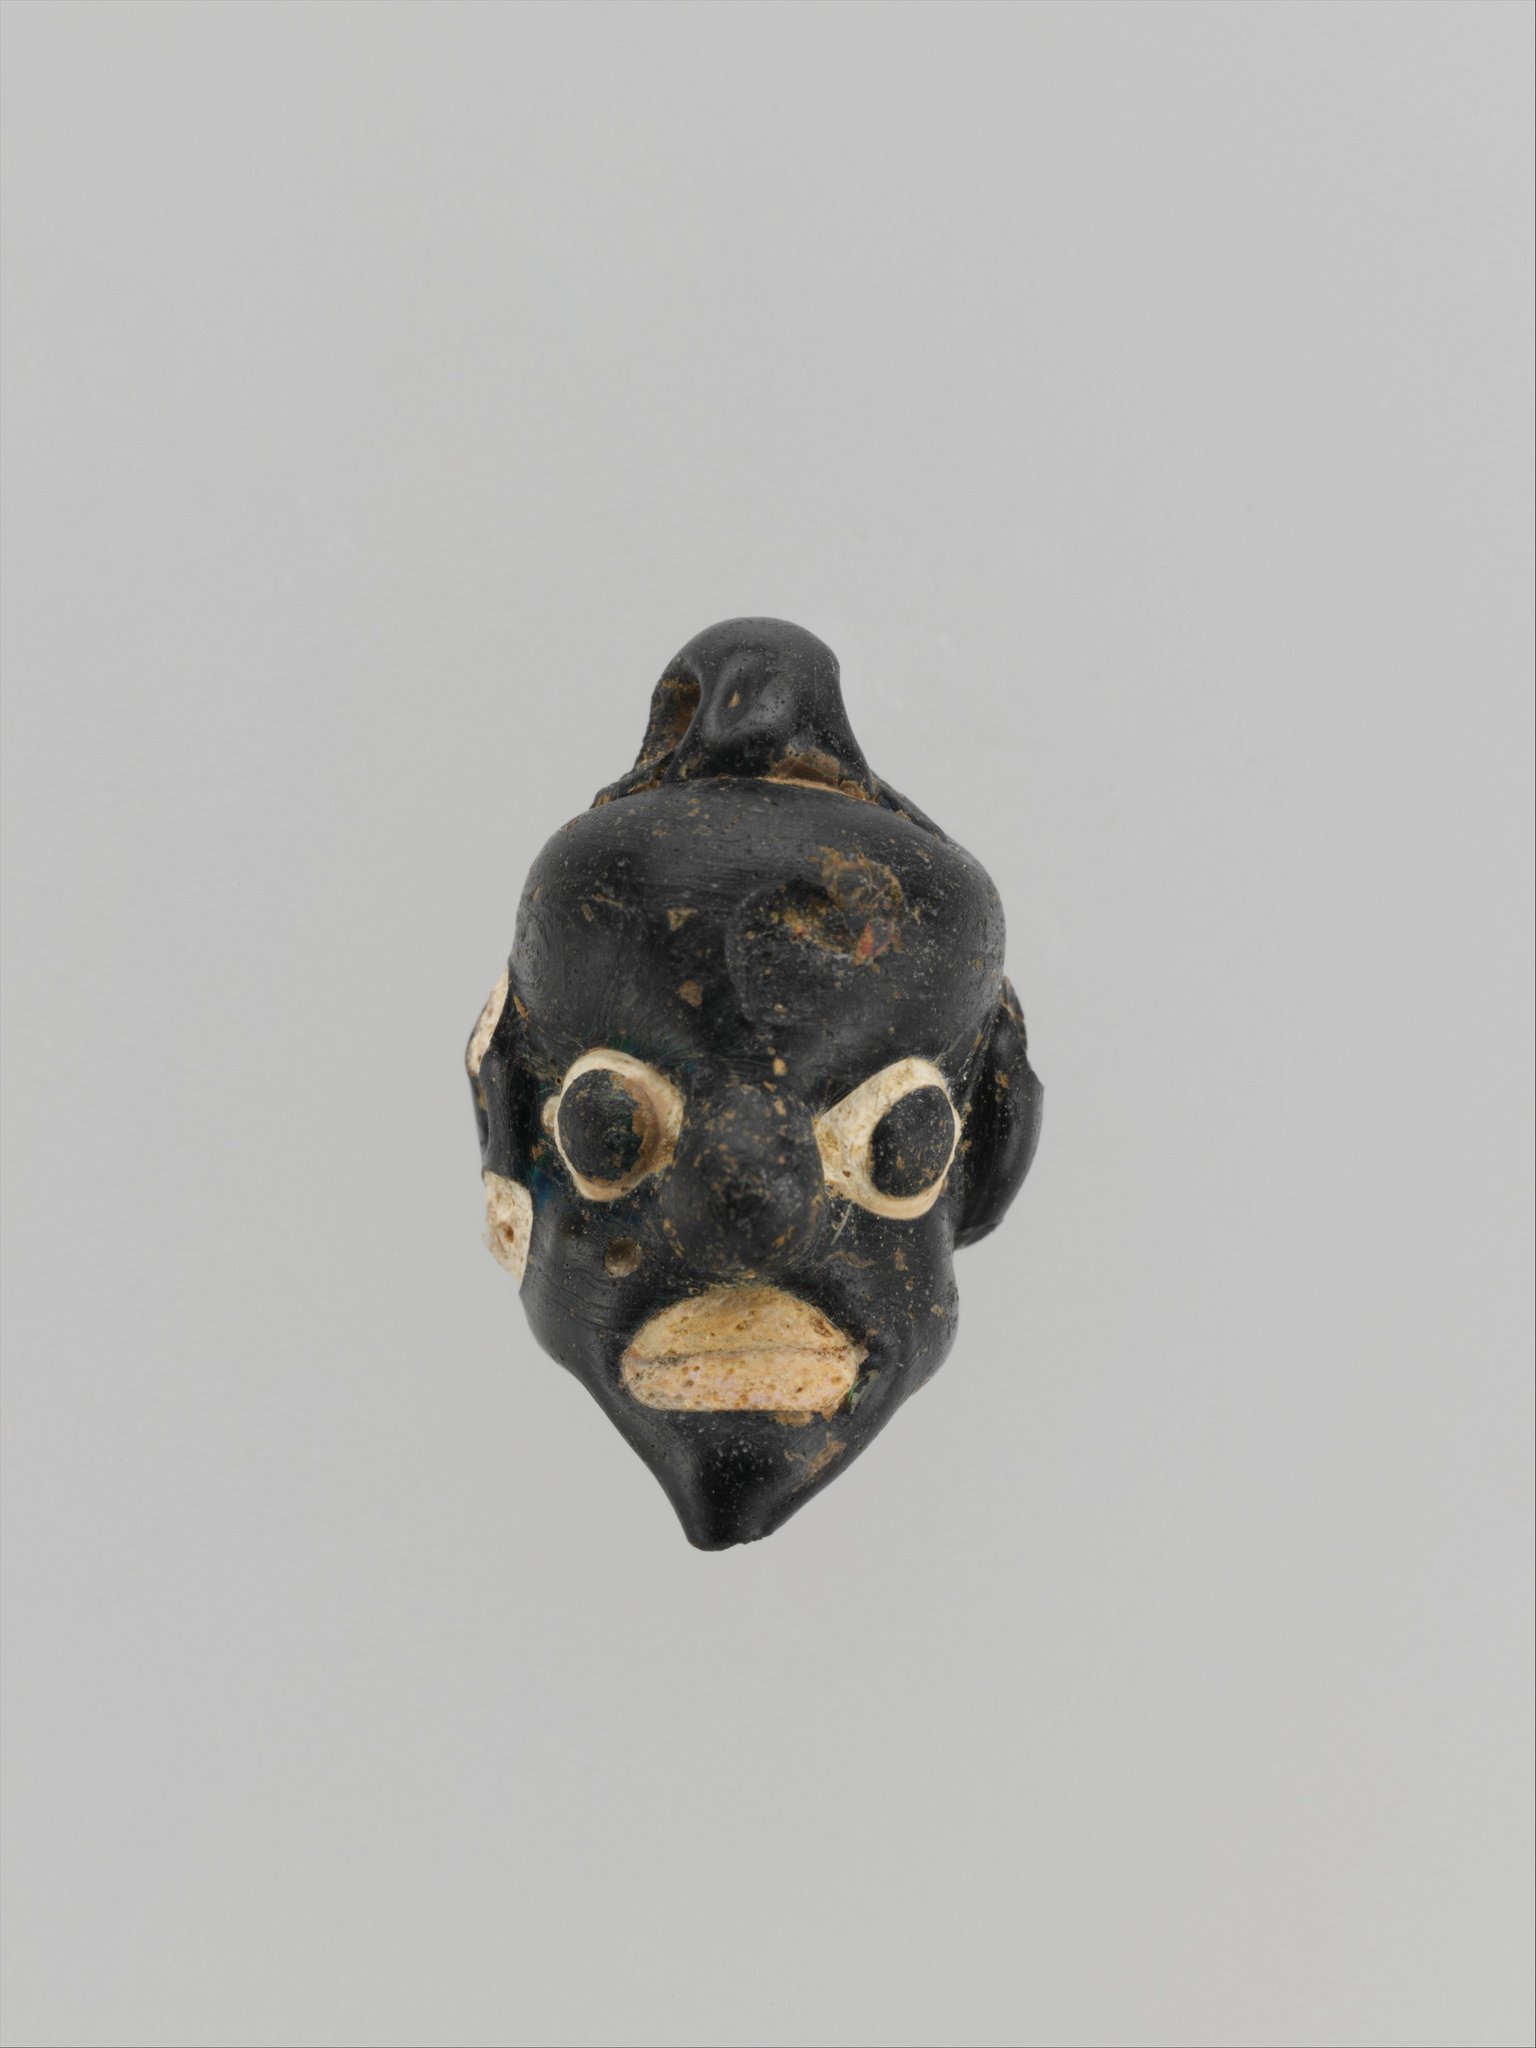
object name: head pendant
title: Glass pendant in the form of a demonic mask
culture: phoenician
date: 467-301 BCE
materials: glass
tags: masks,demons